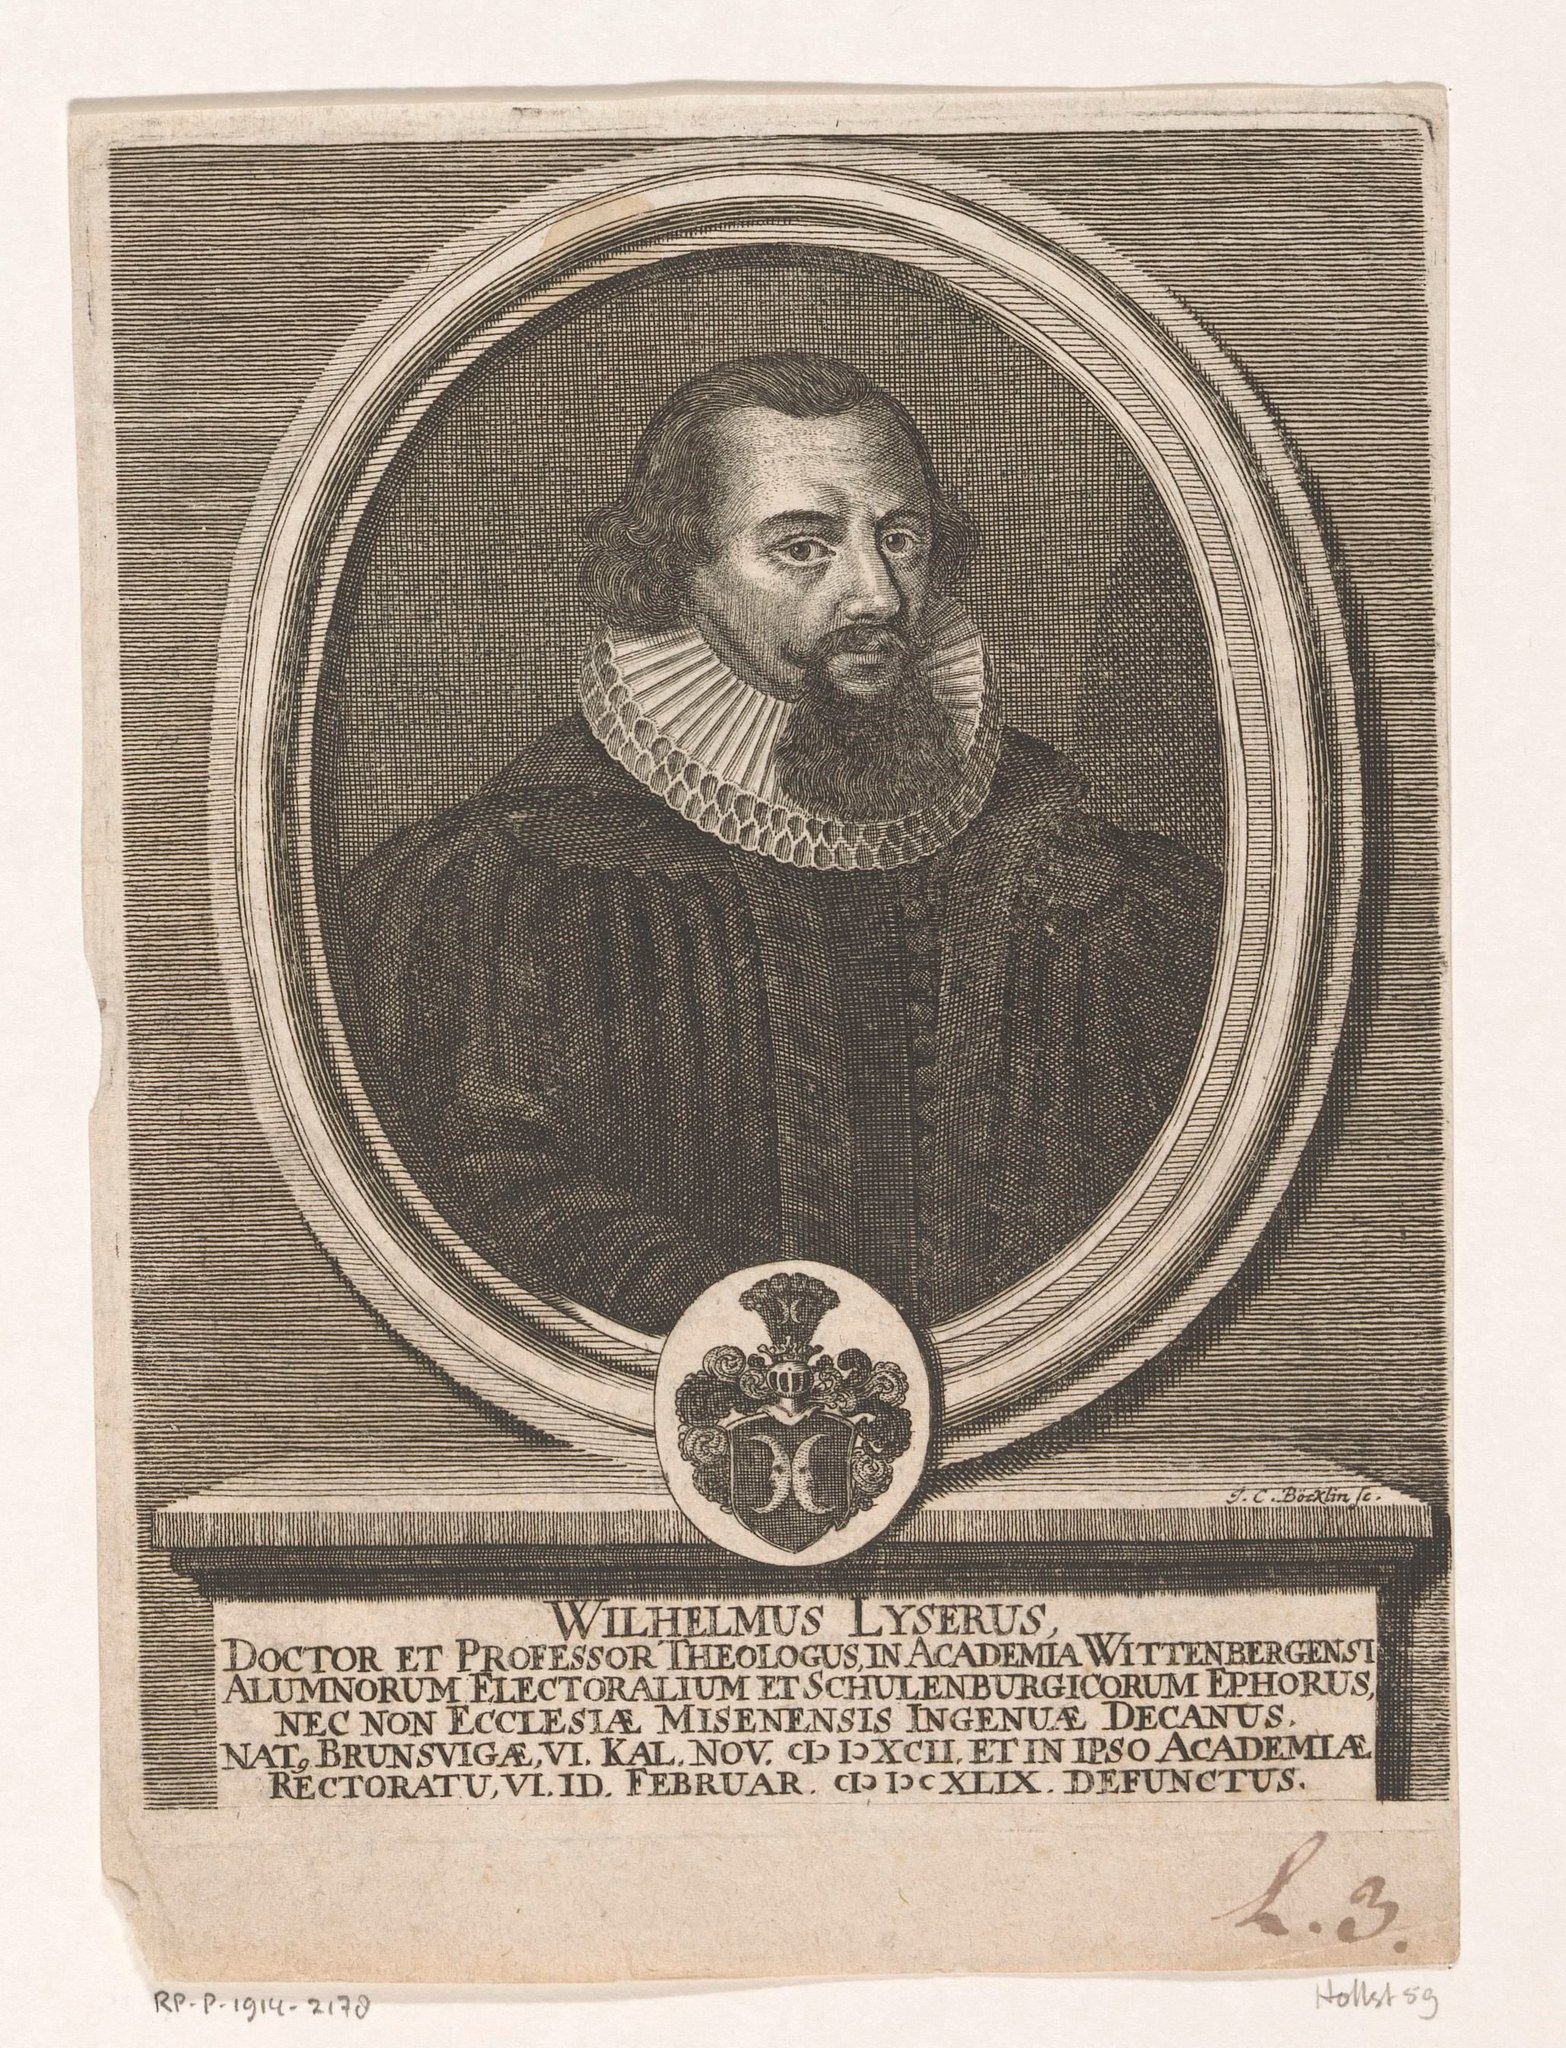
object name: print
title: Portret van Wilhelm Leyser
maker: johann christoph boecklin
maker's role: print maker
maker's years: 1657-1709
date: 1699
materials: paper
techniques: engraving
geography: leipzig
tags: historical persons, armorial bearing, heraldry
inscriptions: collector's mark: Lugt 2228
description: Prent ook gebruikt in: Leyser, Wilhelm. Systema thetico-exegeticum (...) [uitgegeven door] Johann Georg Neumann. Wittenberg: Johann Wilhelm Meyer en Gottfried Zimmermann, 1699.